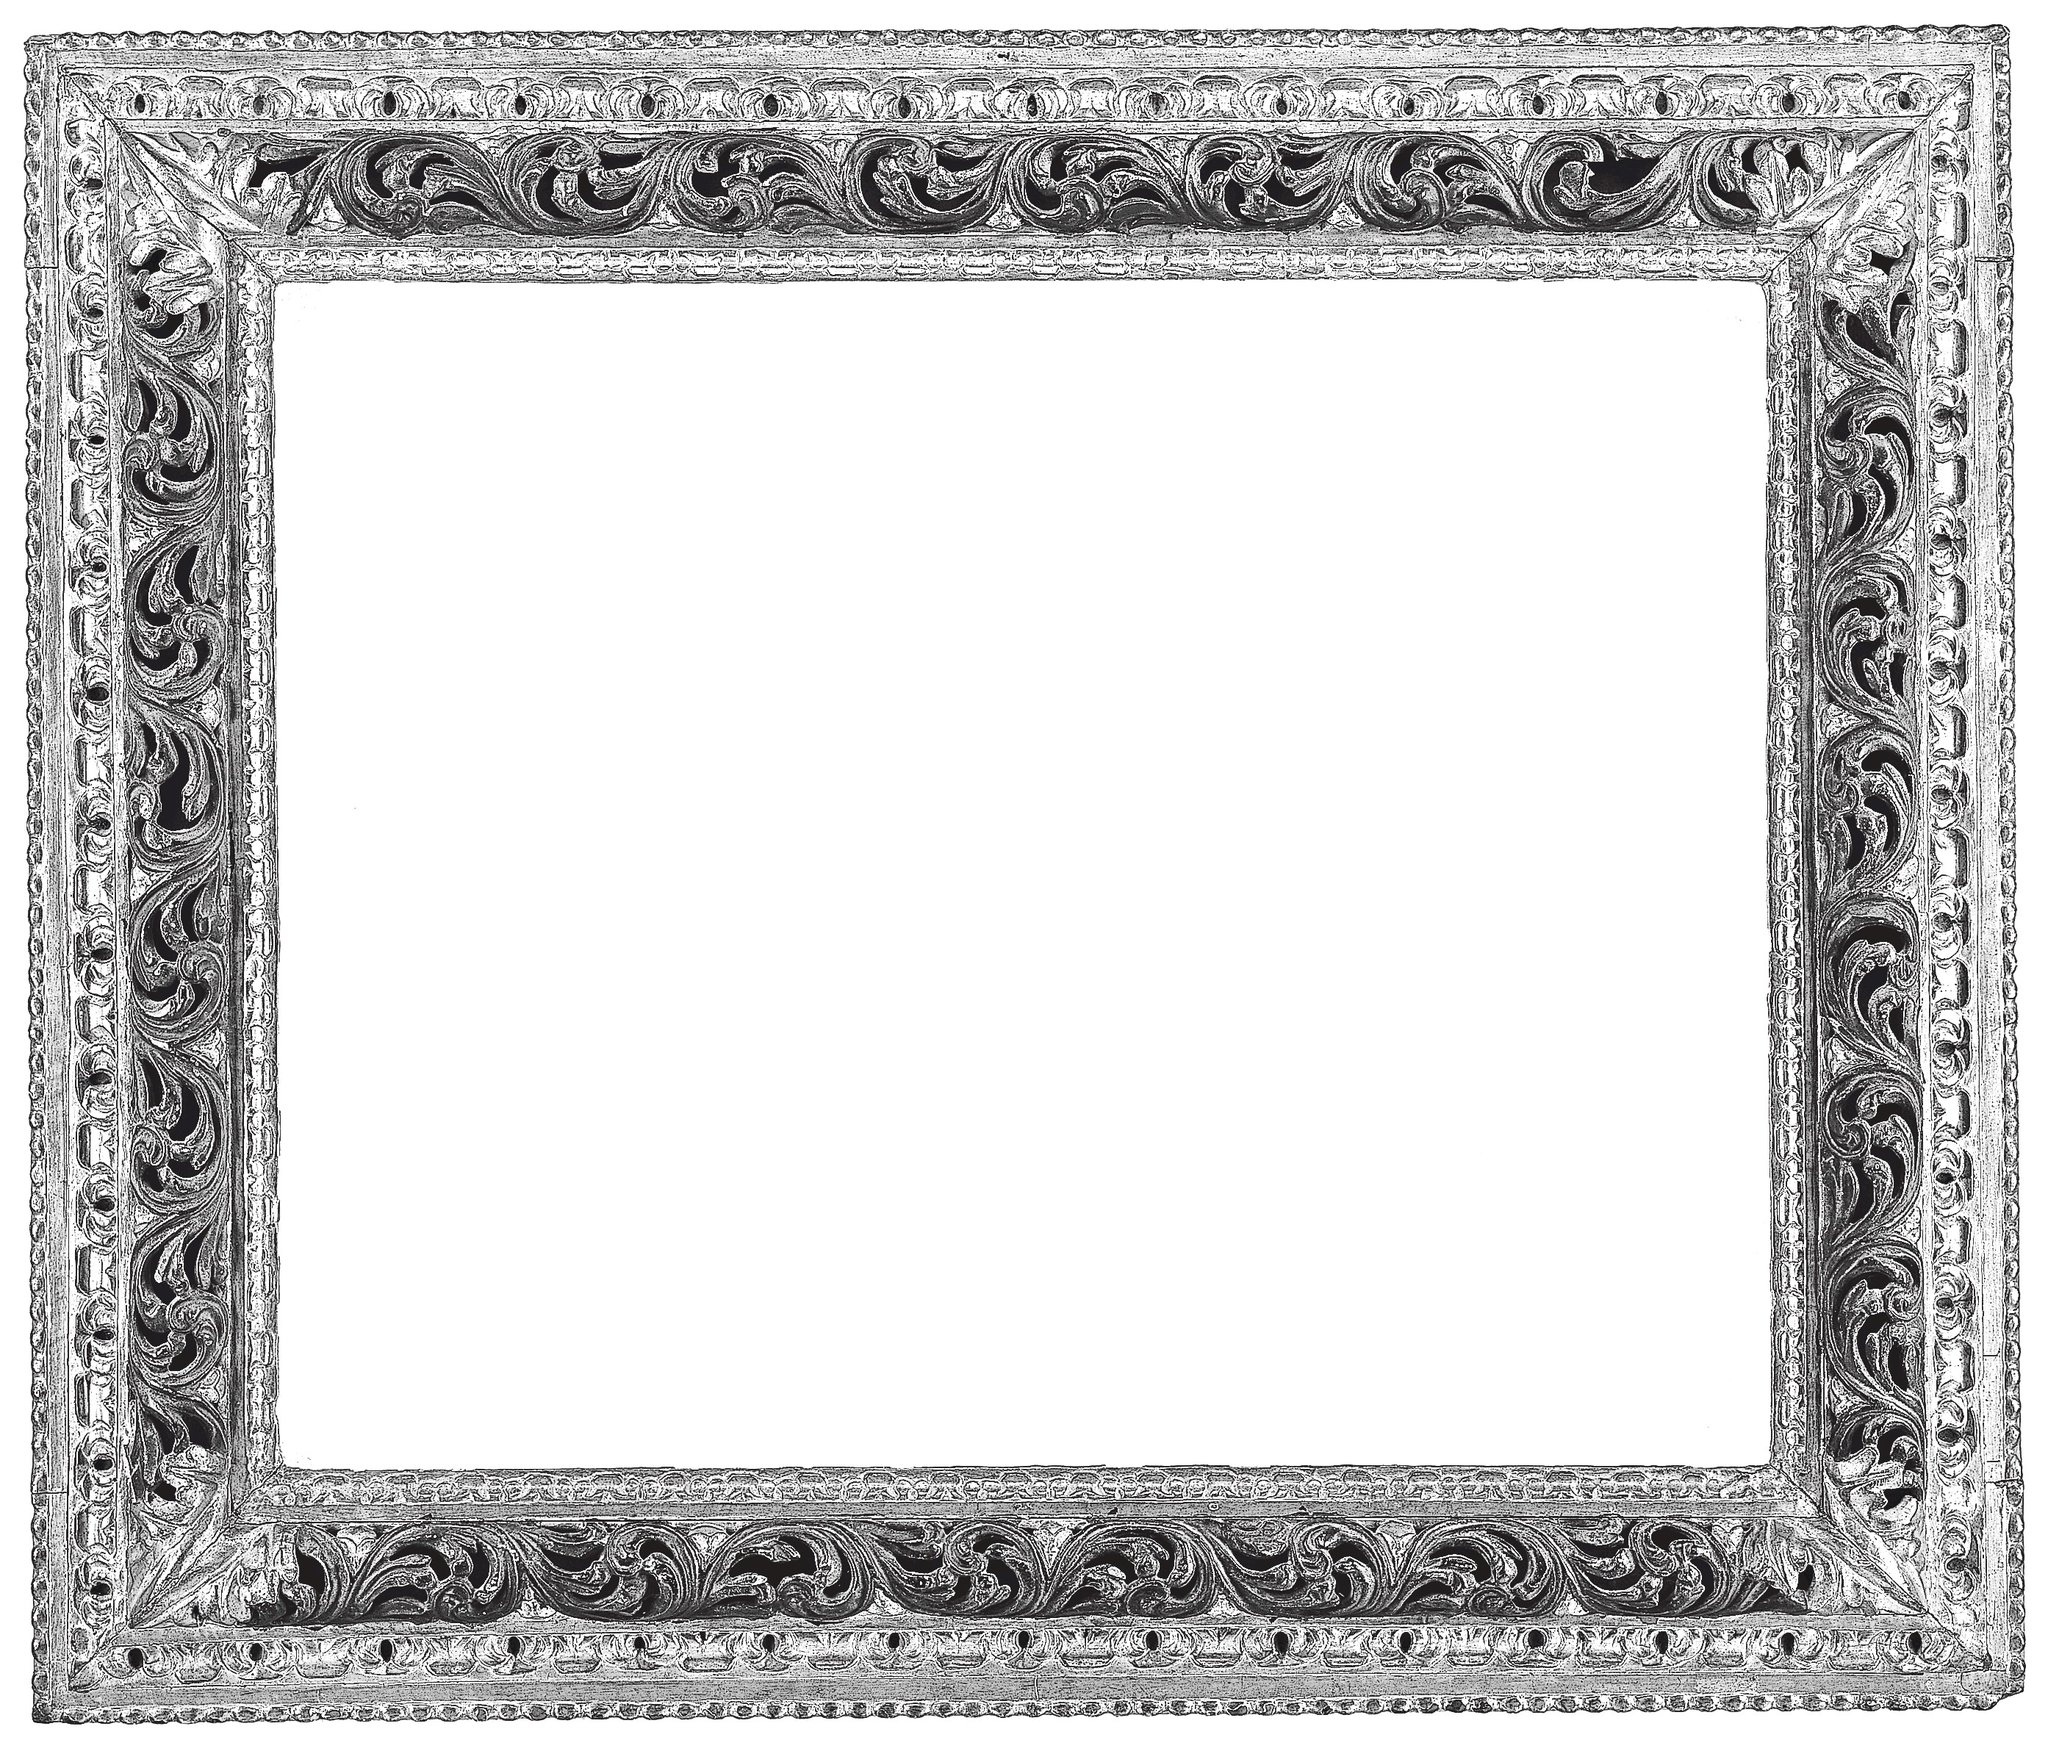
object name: frame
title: Wreath frame (pair with 1975.1.2127)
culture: italian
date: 1567-1600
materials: wood